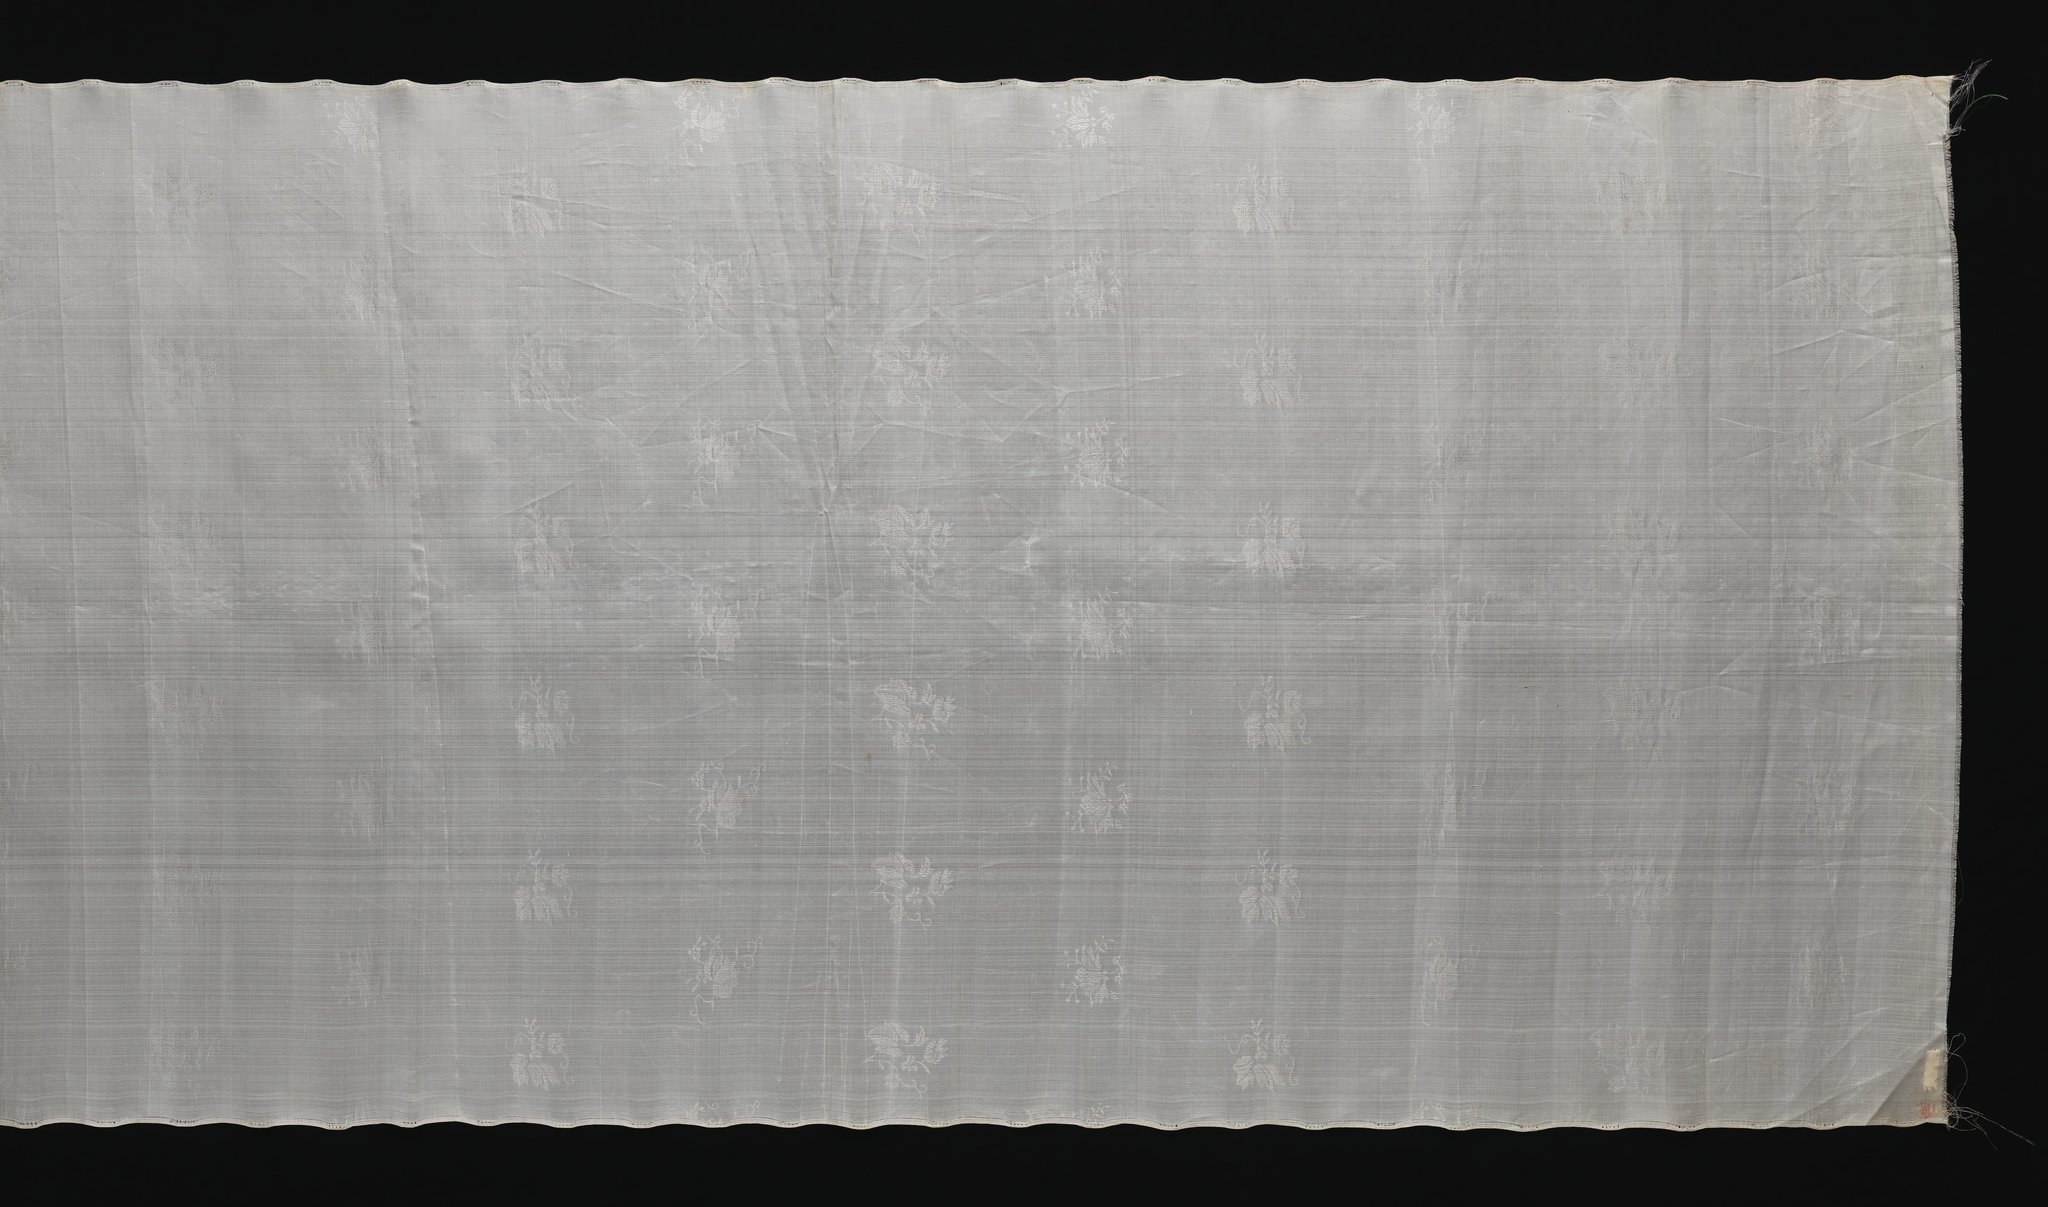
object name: length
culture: korean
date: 1901-1933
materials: silk